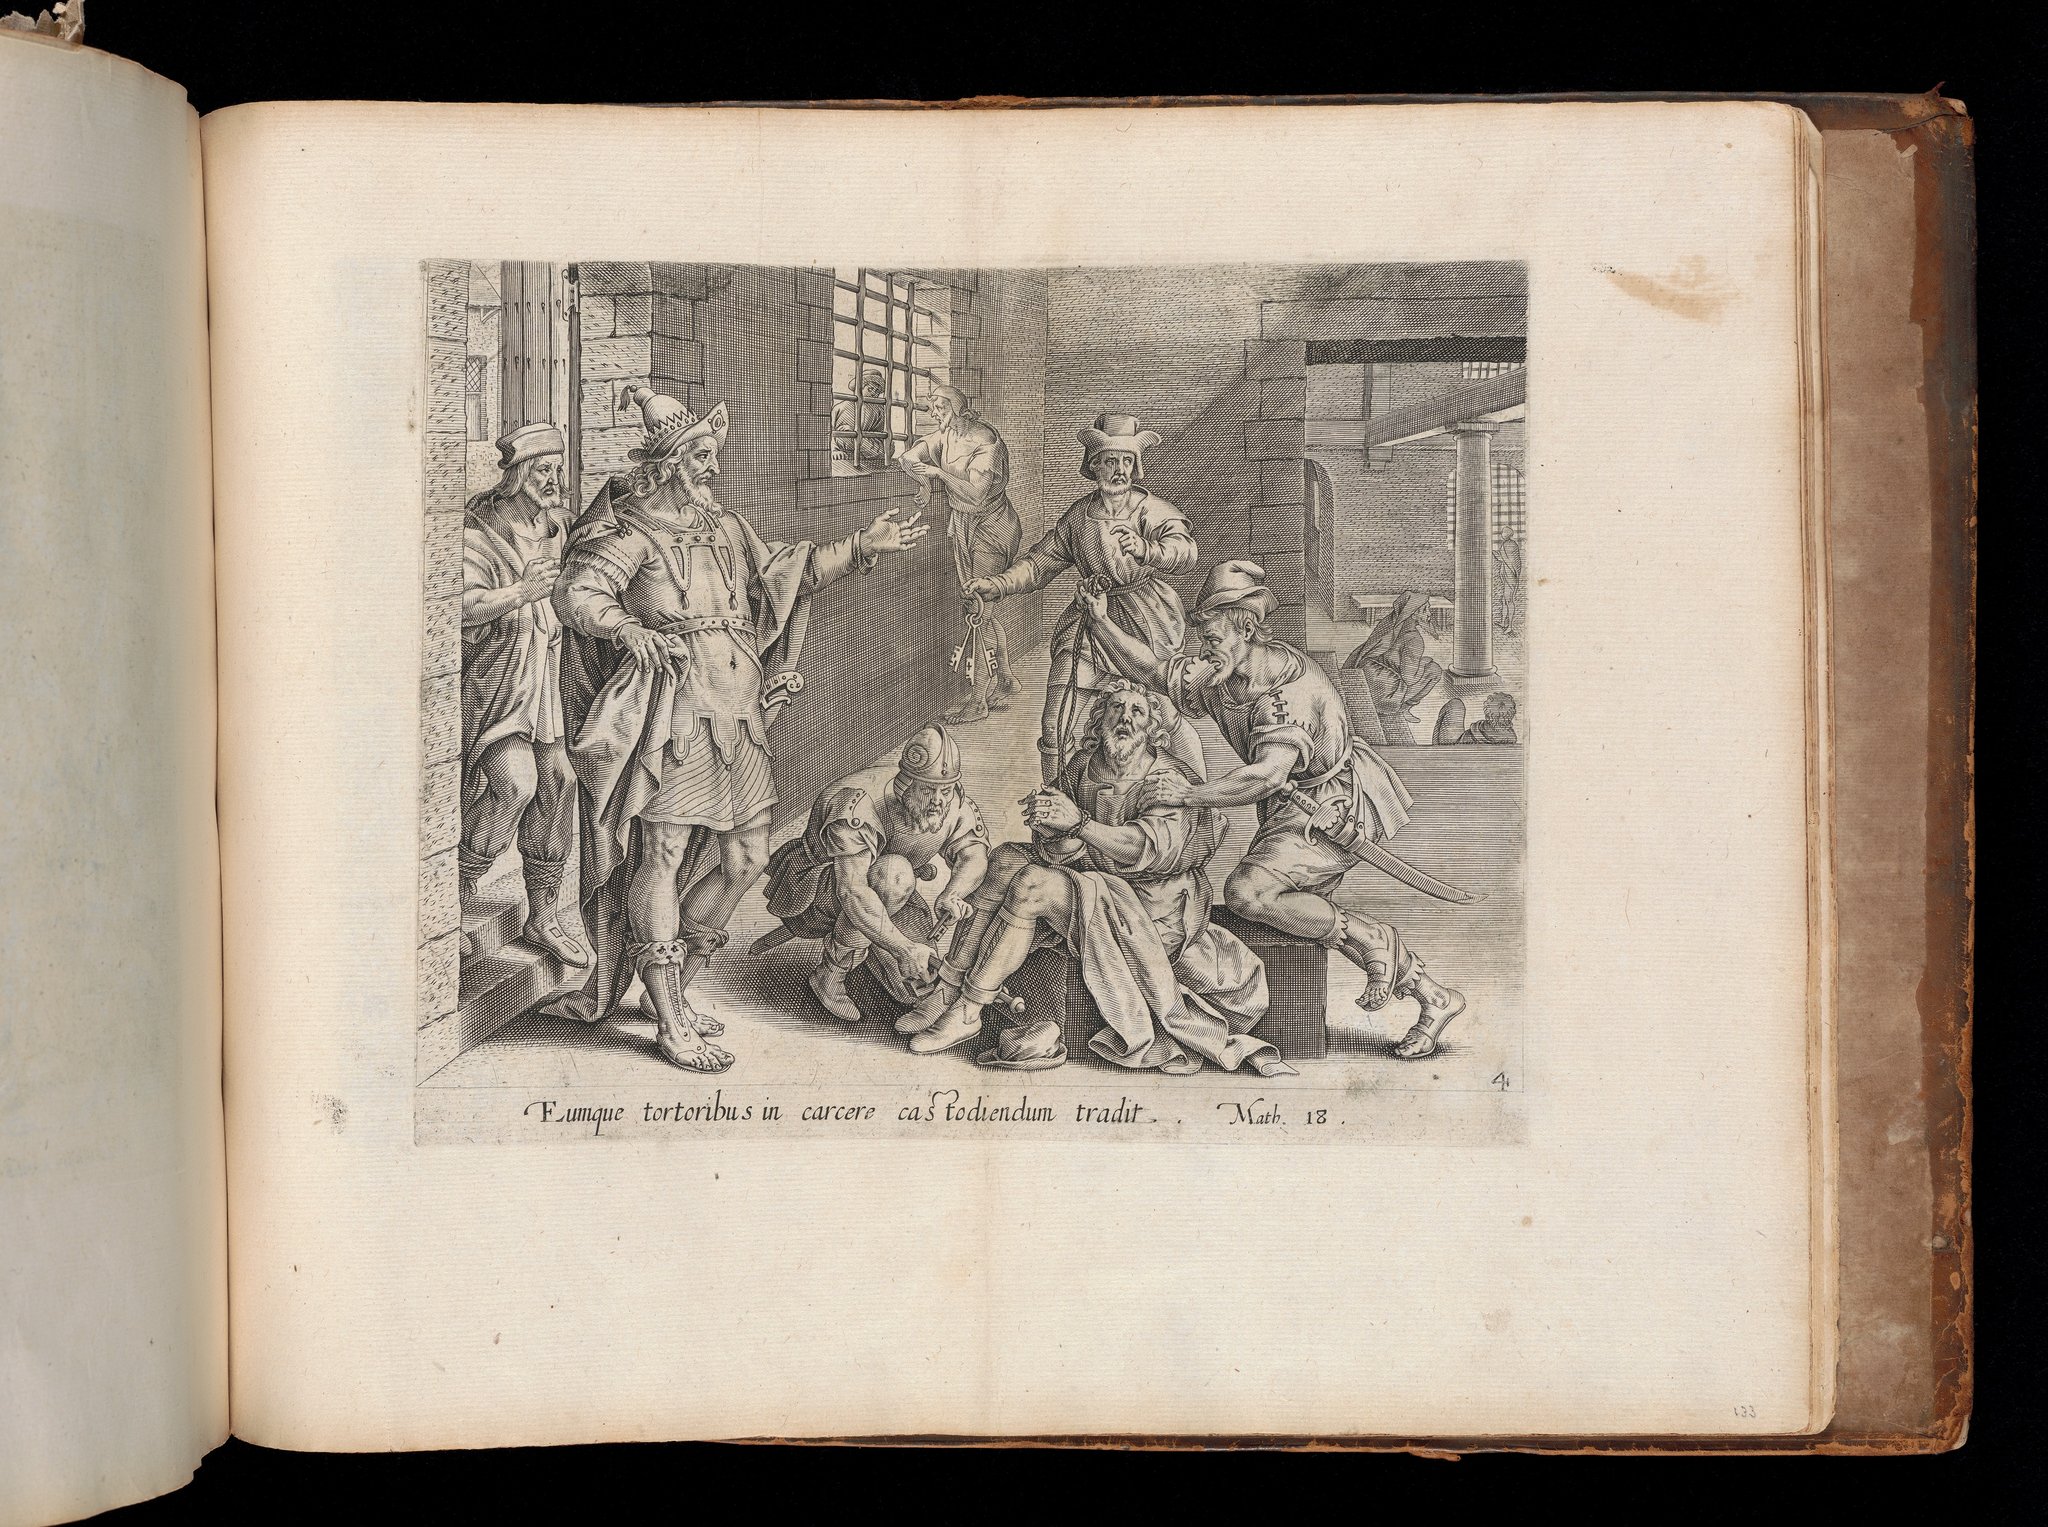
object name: book print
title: The Imprisoned Servant, from The Parable of the Unmerciful Servant, bound in "Thesaurus Sacrarum historiarum Veteris et Novi Testamenti"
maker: anonymous, netherlandish, 16th century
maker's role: engraver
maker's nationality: netherlandish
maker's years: 1500-1600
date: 1585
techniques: engraving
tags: prisons,prisoners,men,servants